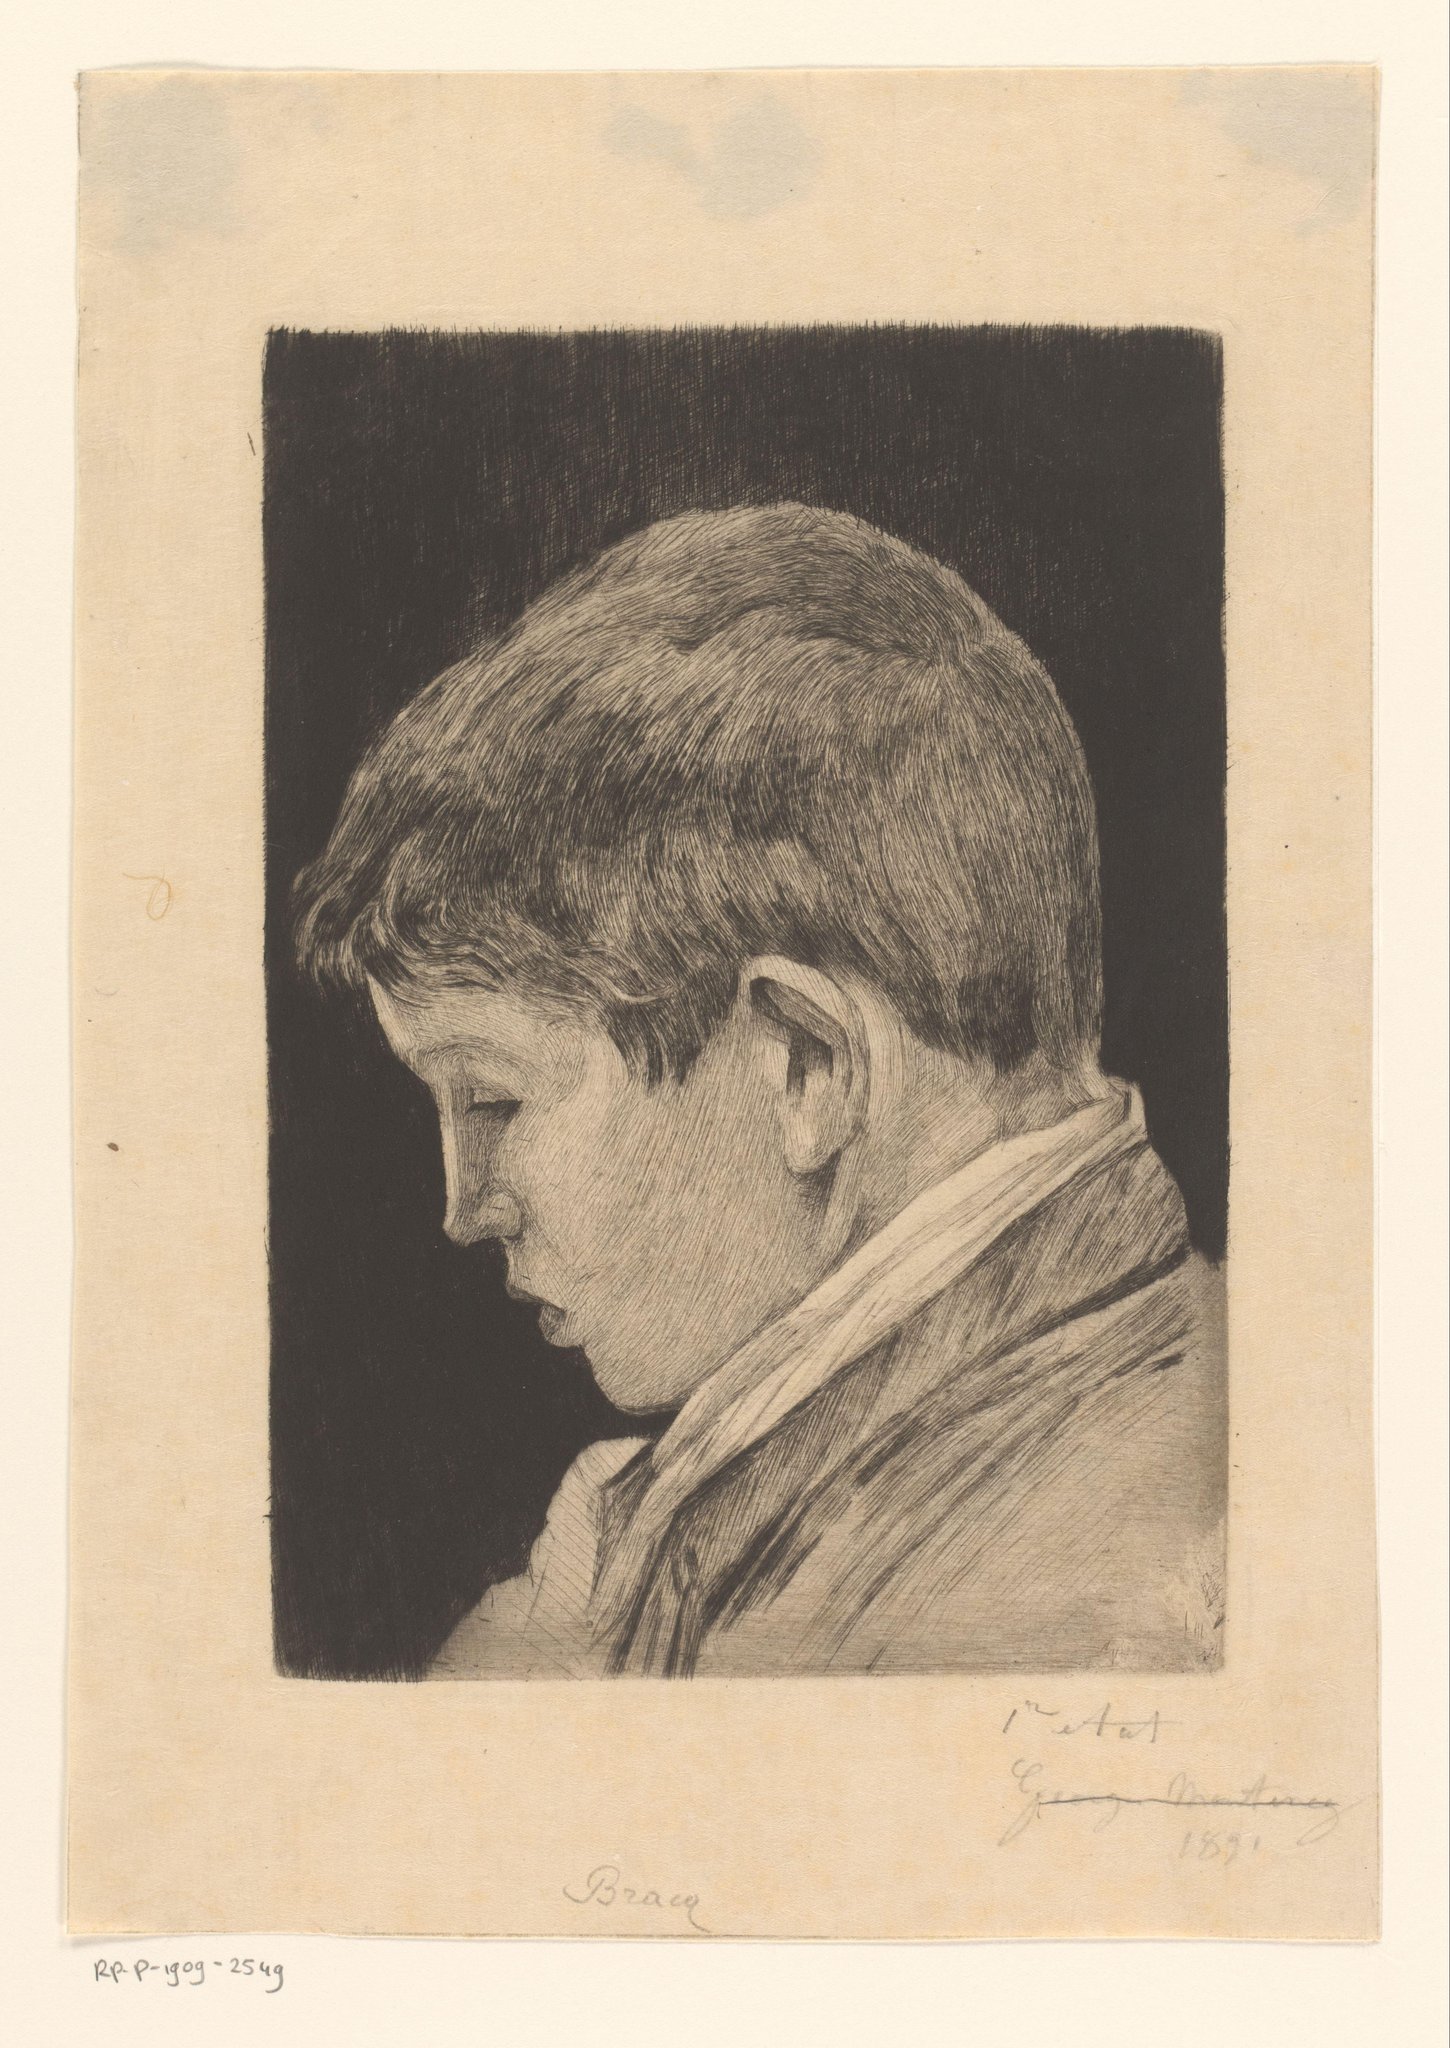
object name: print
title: Portret van August Wilhelm Antonius Neidhardt, Graf von Gneisenau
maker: ludwig buchhorn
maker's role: painter, print maker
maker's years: 1770-1856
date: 1814-1856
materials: paper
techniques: stippling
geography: berlin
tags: knighthood order (with name) - insignia of a knighthood order, e.g.: badge, chain (with name of order), historical persons, (military) uniforms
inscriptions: collector's mark: Lugt 2228